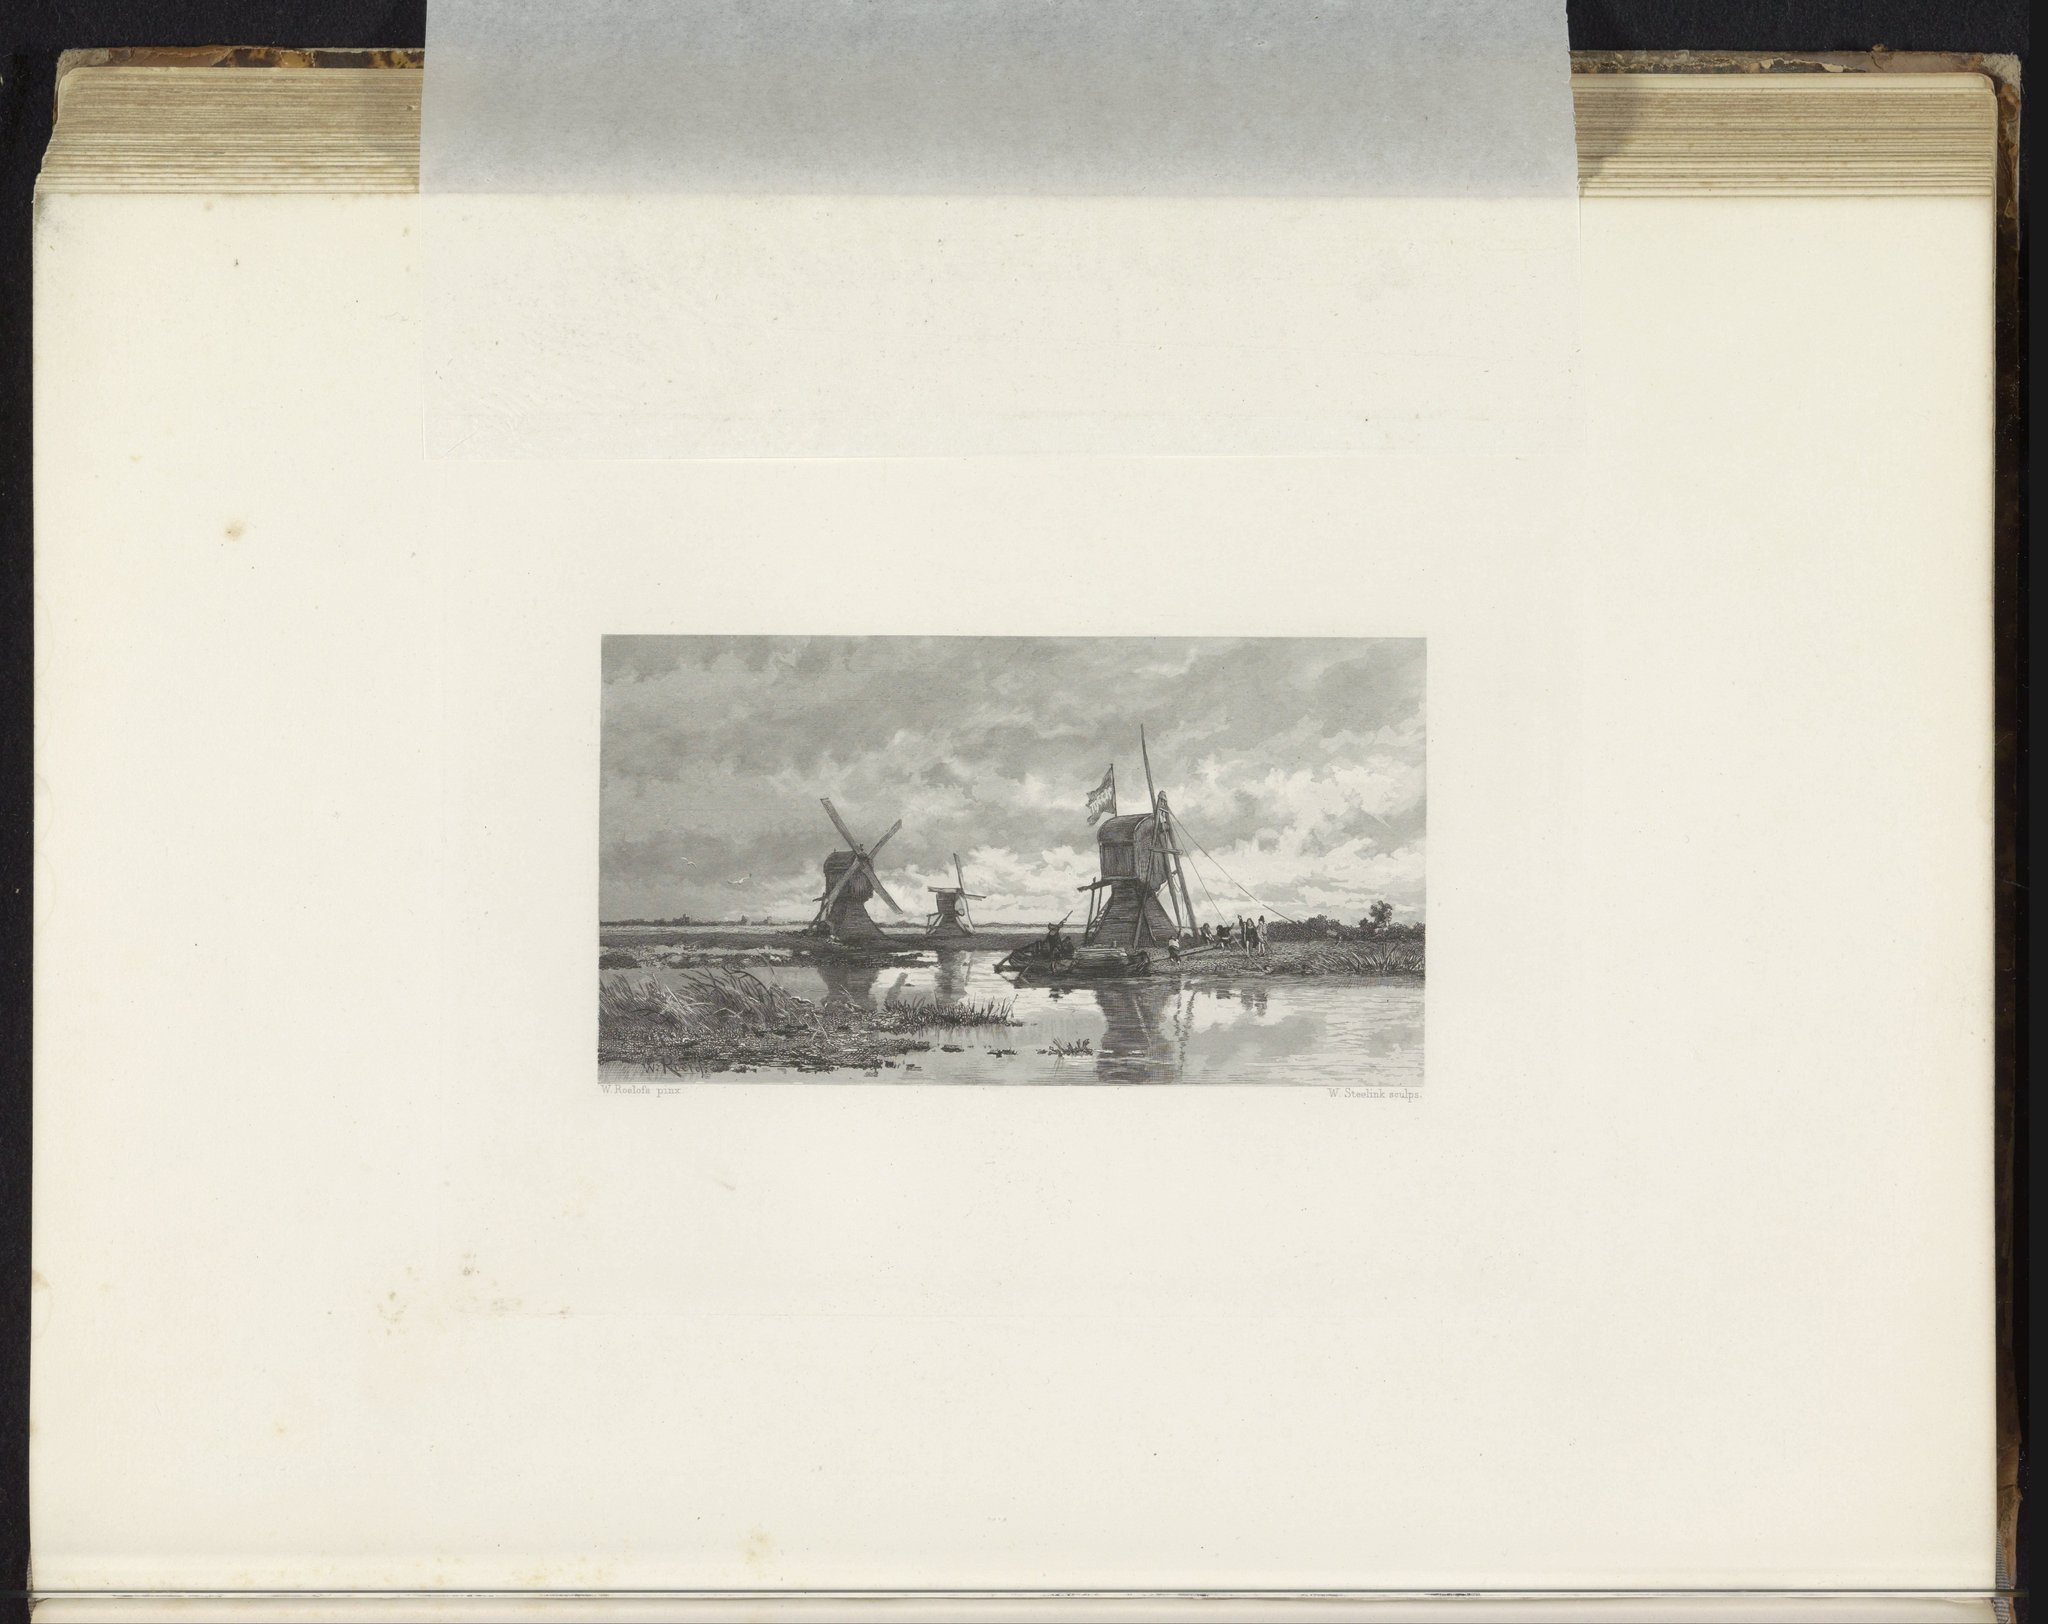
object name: print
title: De eerste windwatermolens in Holland in de veertiende eeuw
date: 1865-1870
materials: paper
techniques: engraving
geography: netherlands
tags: windmill, netherlands, burgundian netherlands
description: De eerste windmolens worden in Holland in bedrijf genomen, 14e eeuw. Waterlandschap met drie molens. Onderdeel van de groep staalgravures naar de schilderijen van de Historische Galerij der Maatschappij Arti et Amicitiae.